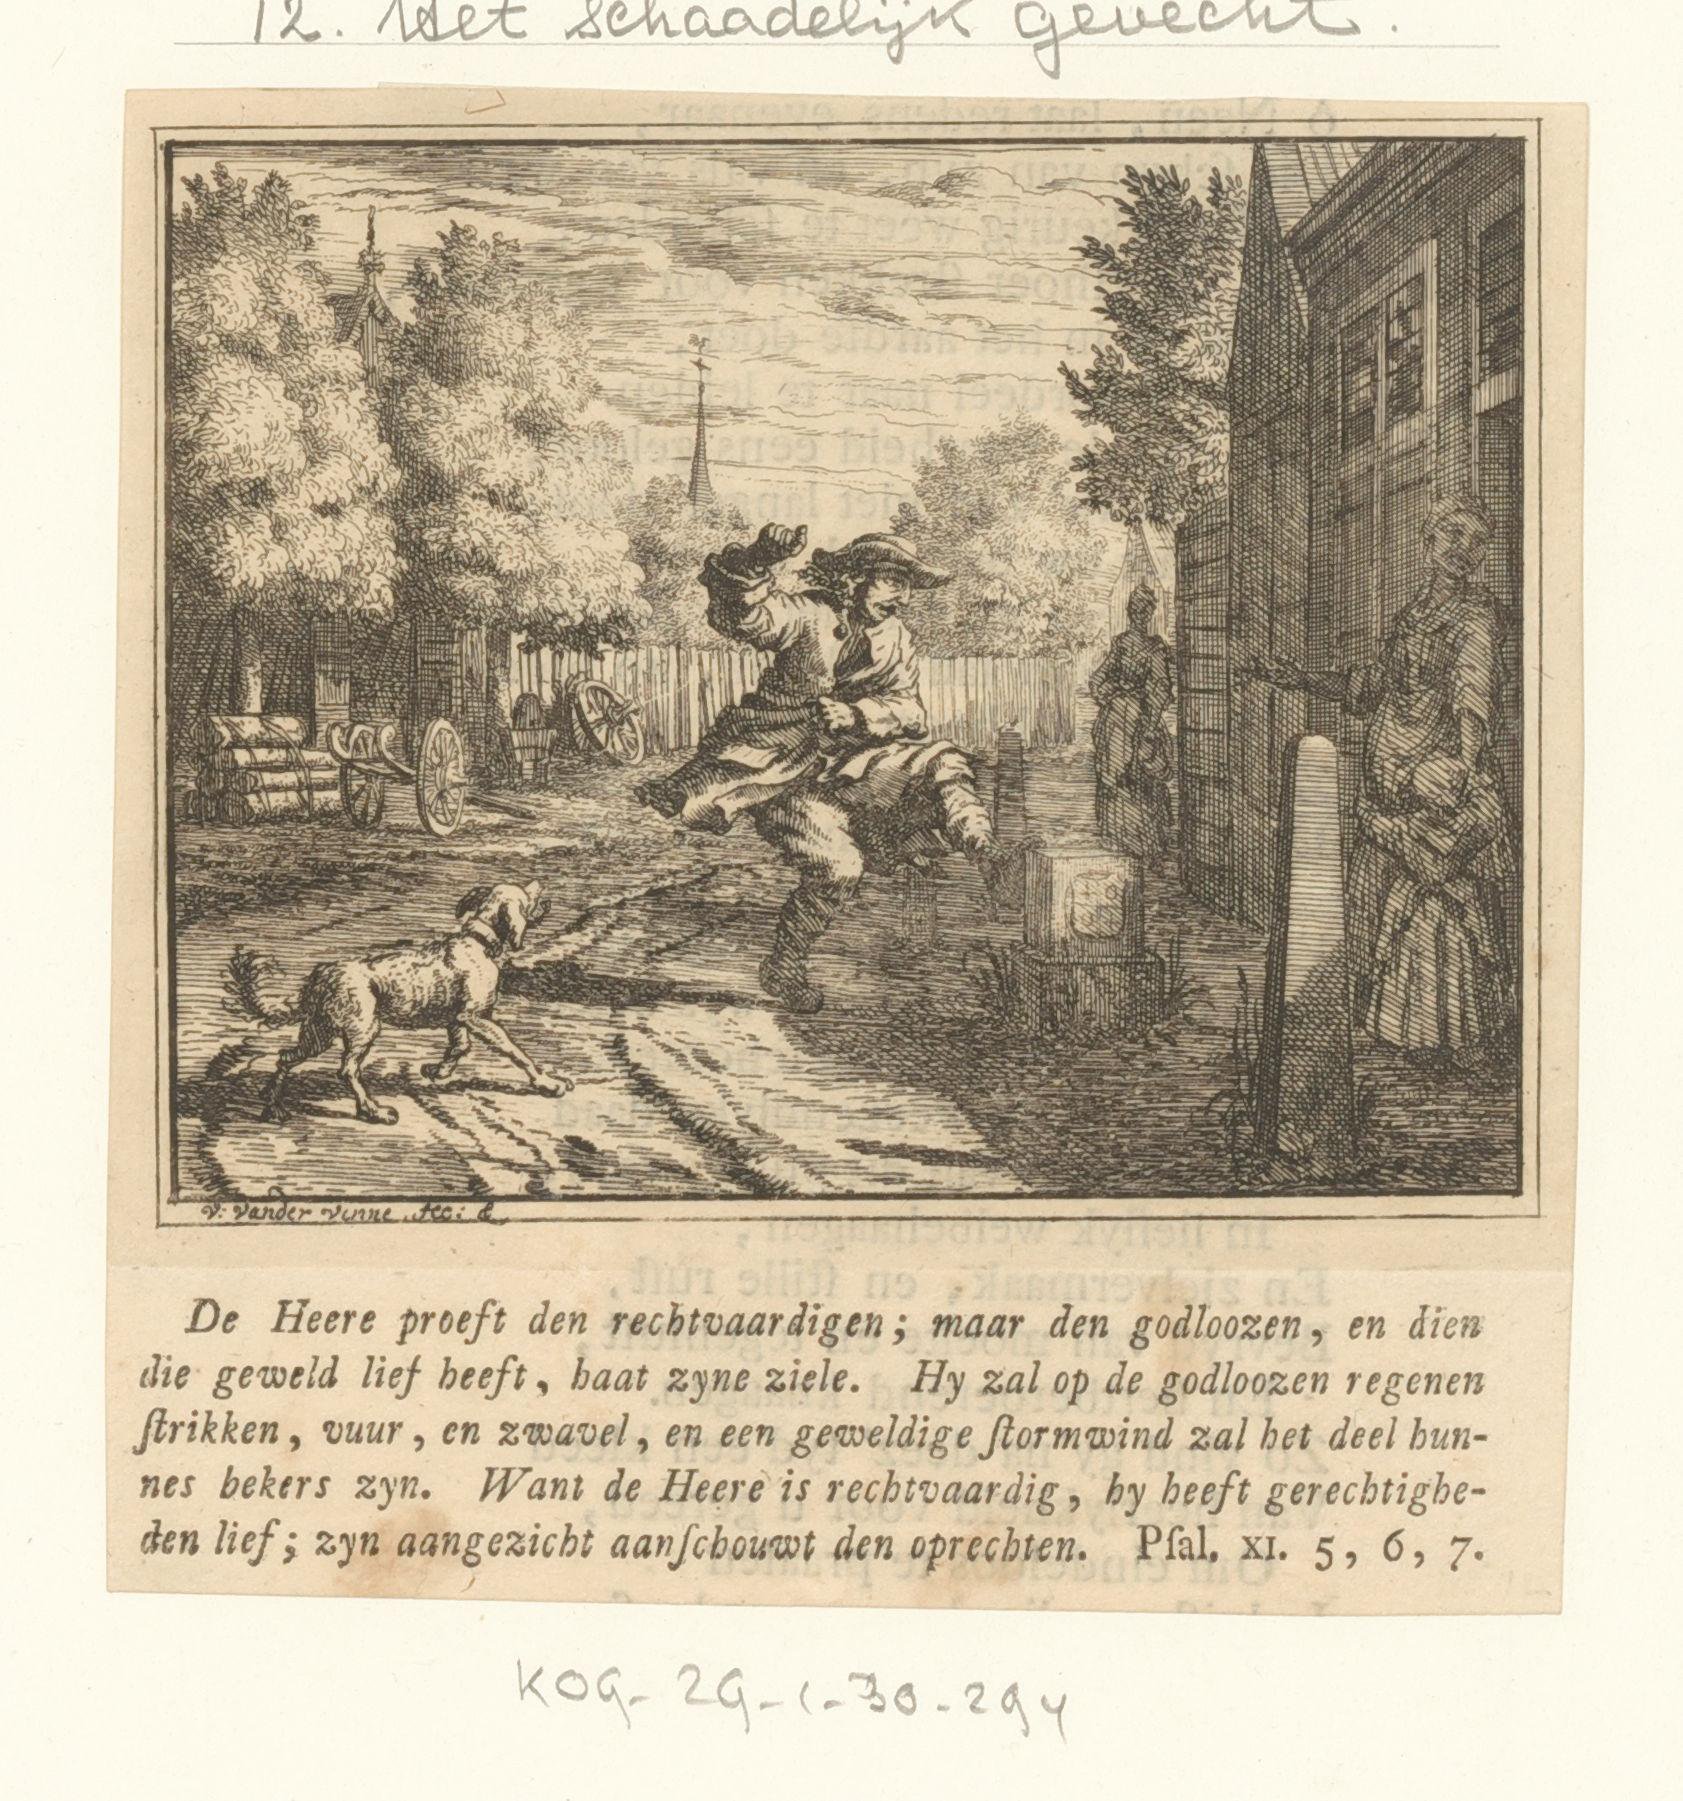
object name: print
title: Boze man op straat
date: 1758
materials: paper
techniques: etching, letterpress printing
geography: haarlem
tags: proverbs, sayings, etc., street, dog, fist-fight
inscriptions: stamp, collector's mark: Lugt 1641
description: Embleem bij het motto: Het schaadelijk gevecht. Onderaan een vijfregelige tekst in het Nederlands. Onderwerpsrubrieken binnen de Atlas Zeden en Gewoonten: Zeden en Gewoonten in engeren zin. Volksleven. Zinnebeeldige voorstellingen uit het volkleven op serieprenten. Maanden en diversen (allegorieën).